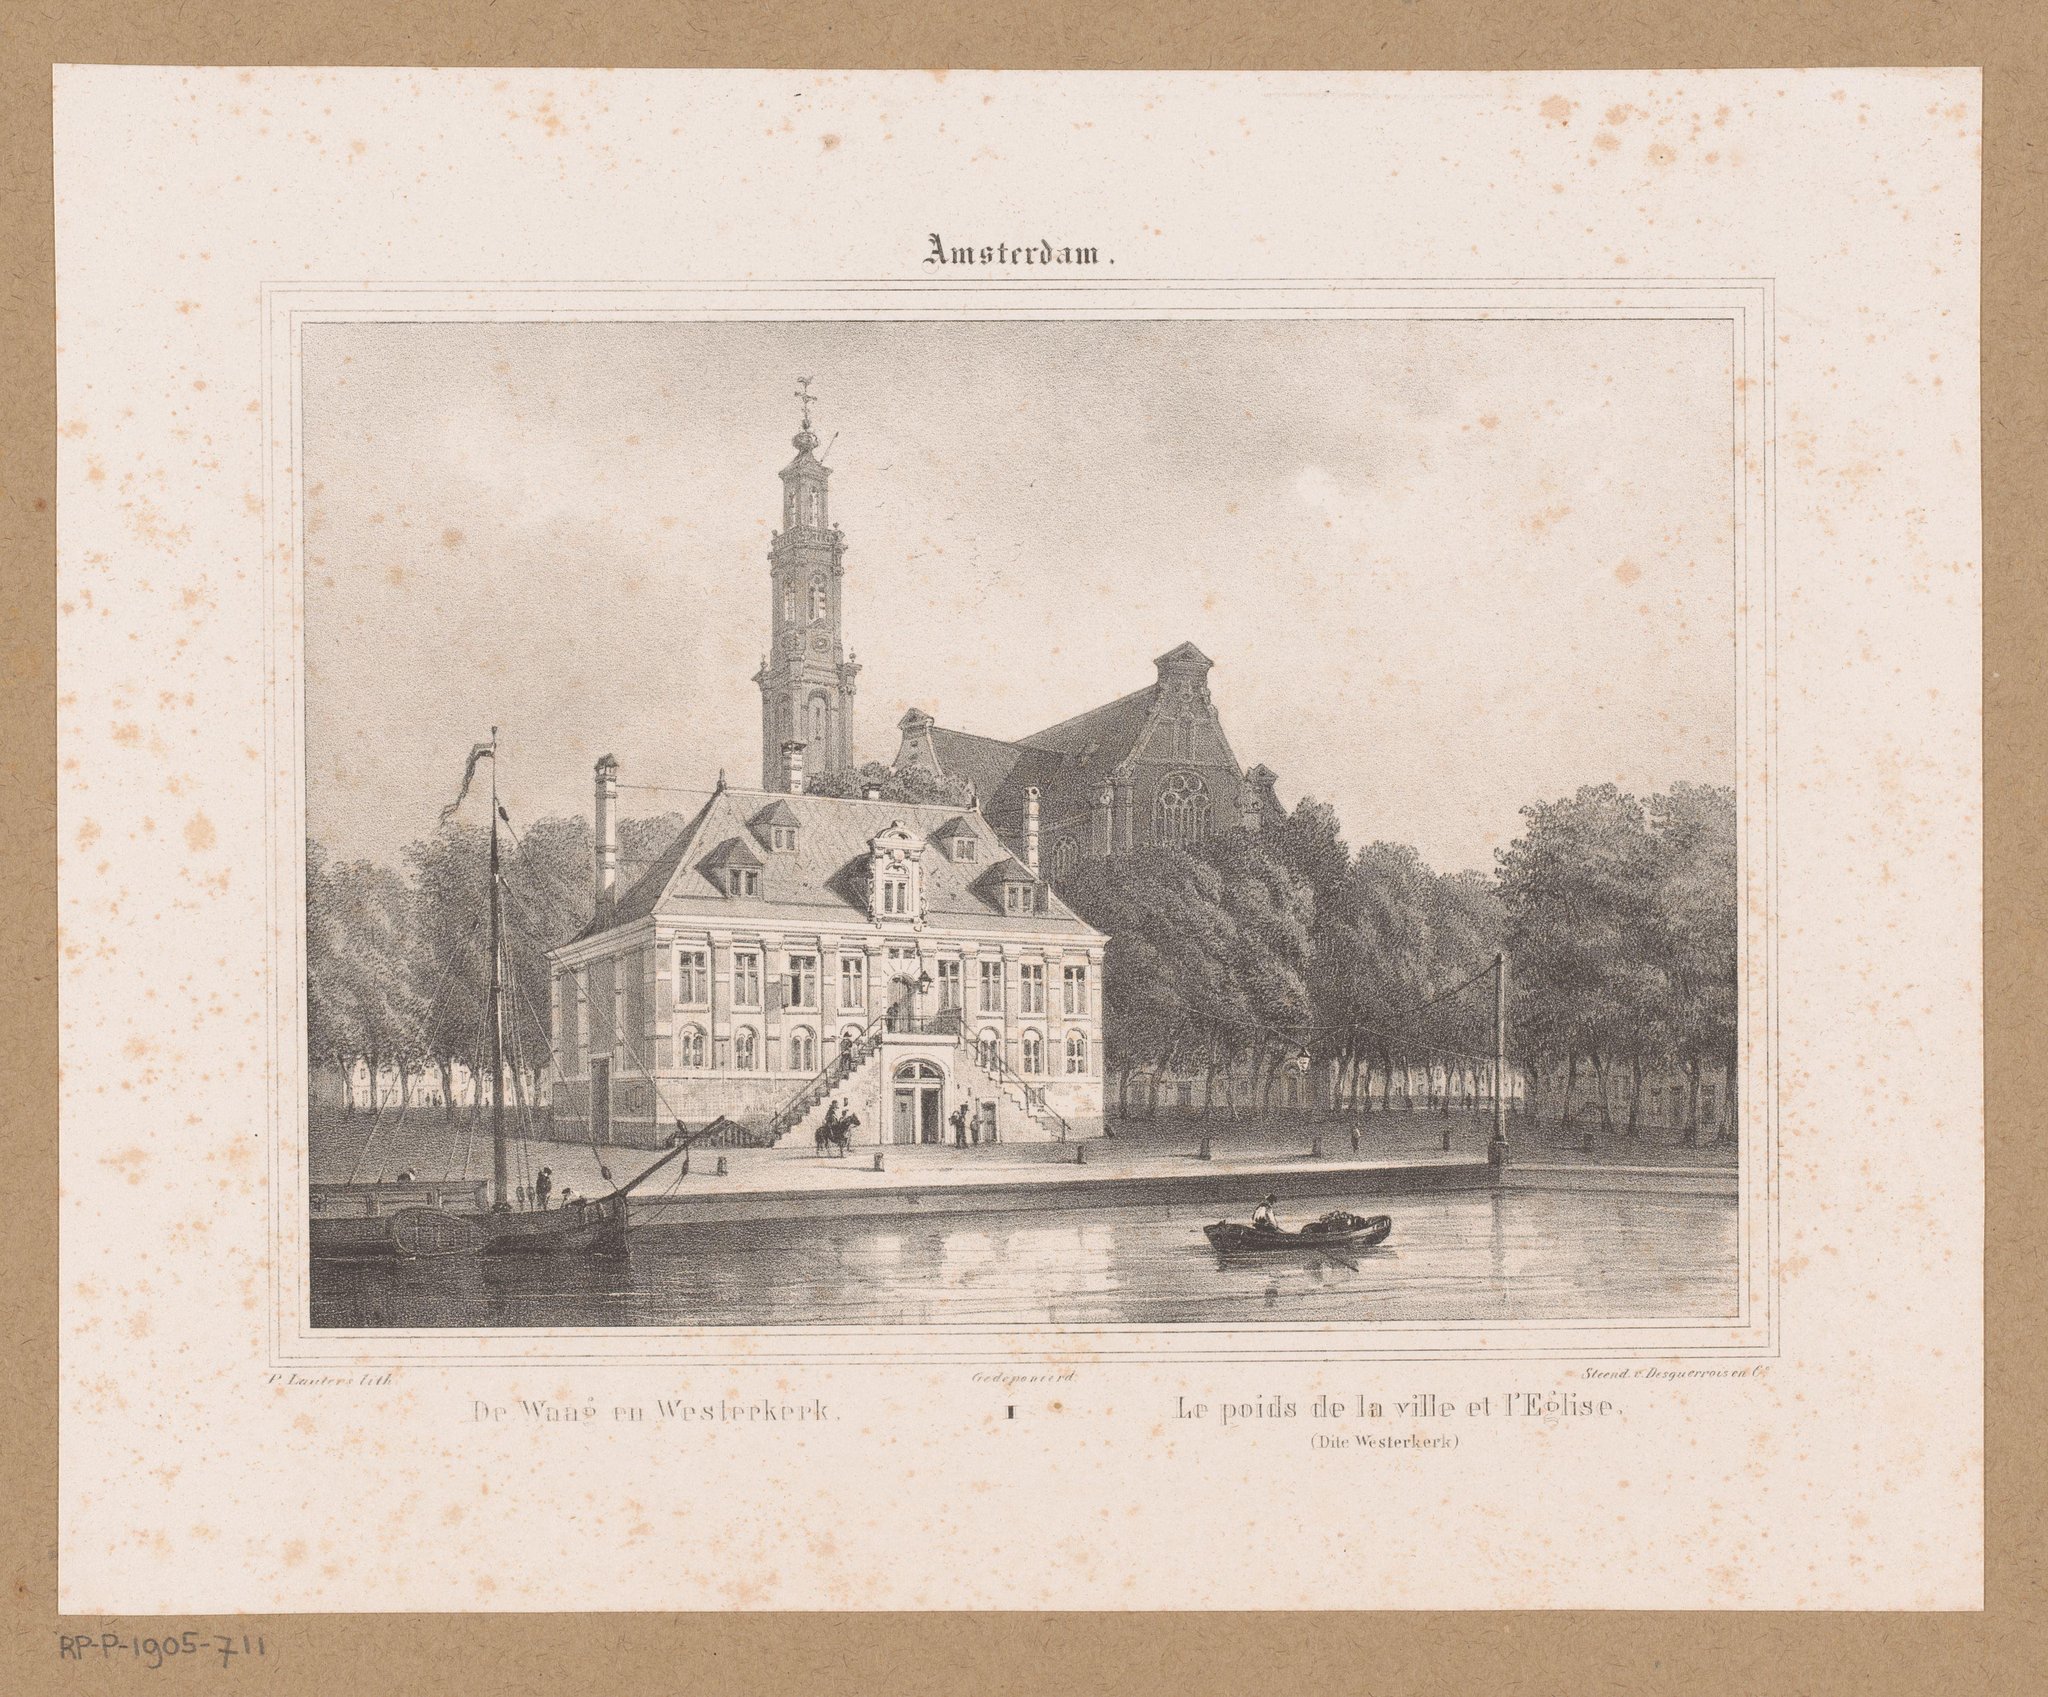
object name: print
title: Gezicht op de Westerhal en Westerkerk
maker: paulus lauters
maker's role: print maker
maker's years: 1806-1875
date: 1836-1840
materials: paper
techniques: lithograph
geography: amsterdam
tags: city-view in general; 'veduta', church (exterior), weigh-house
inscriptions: collector's mark: Lugt 2228, : ‘Gedeponeerd.’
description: Prent maakt onderdeel uit van de serie: Hoofdgebouwen en gezichten der Voornaamste Steden van Holland. Onder deze naam werden in ieder geval verschillende stadgezichten gepubliceerd in de jaren 1836, 1839 en 1840 door Desguerrois & Co.